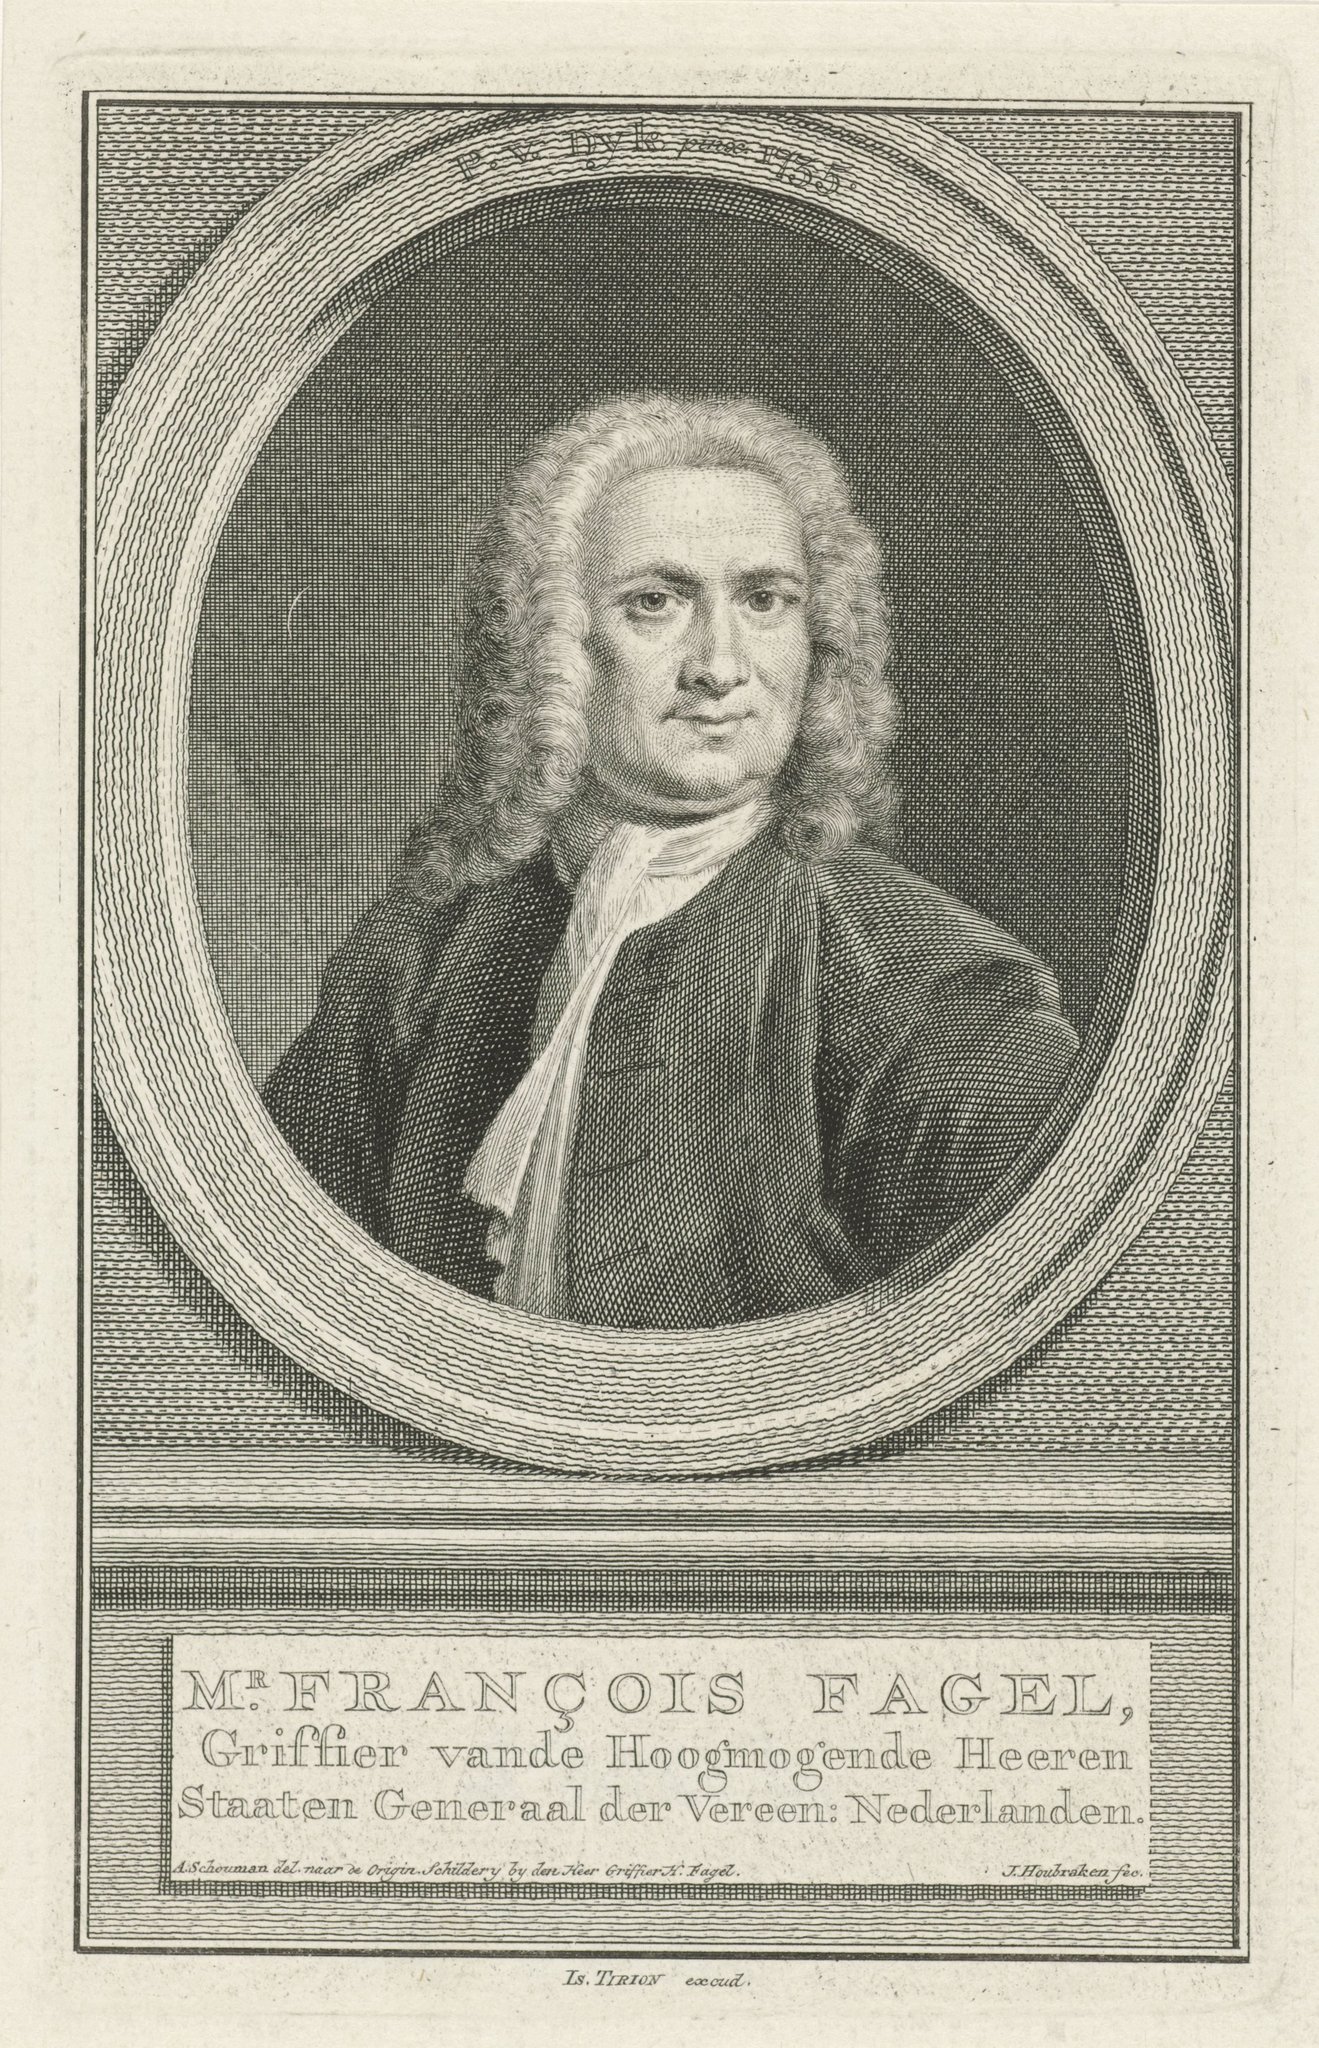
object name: print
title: Mr. François Fagel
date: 1749-1759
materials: paper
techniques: engraving, etching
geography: amsterdam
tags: françois fagel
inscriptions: collector's mark: Lugt 2228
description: Prent ook gebruikt in: Jan Wagenaar, Vaderlandsche historie, vervattende de geschiedenissen der nu Vereenigde Nederlanden, inzonderheid die van Holland (...), 21 delen. Amsterdam, Isaak Tirion, 1749-59.